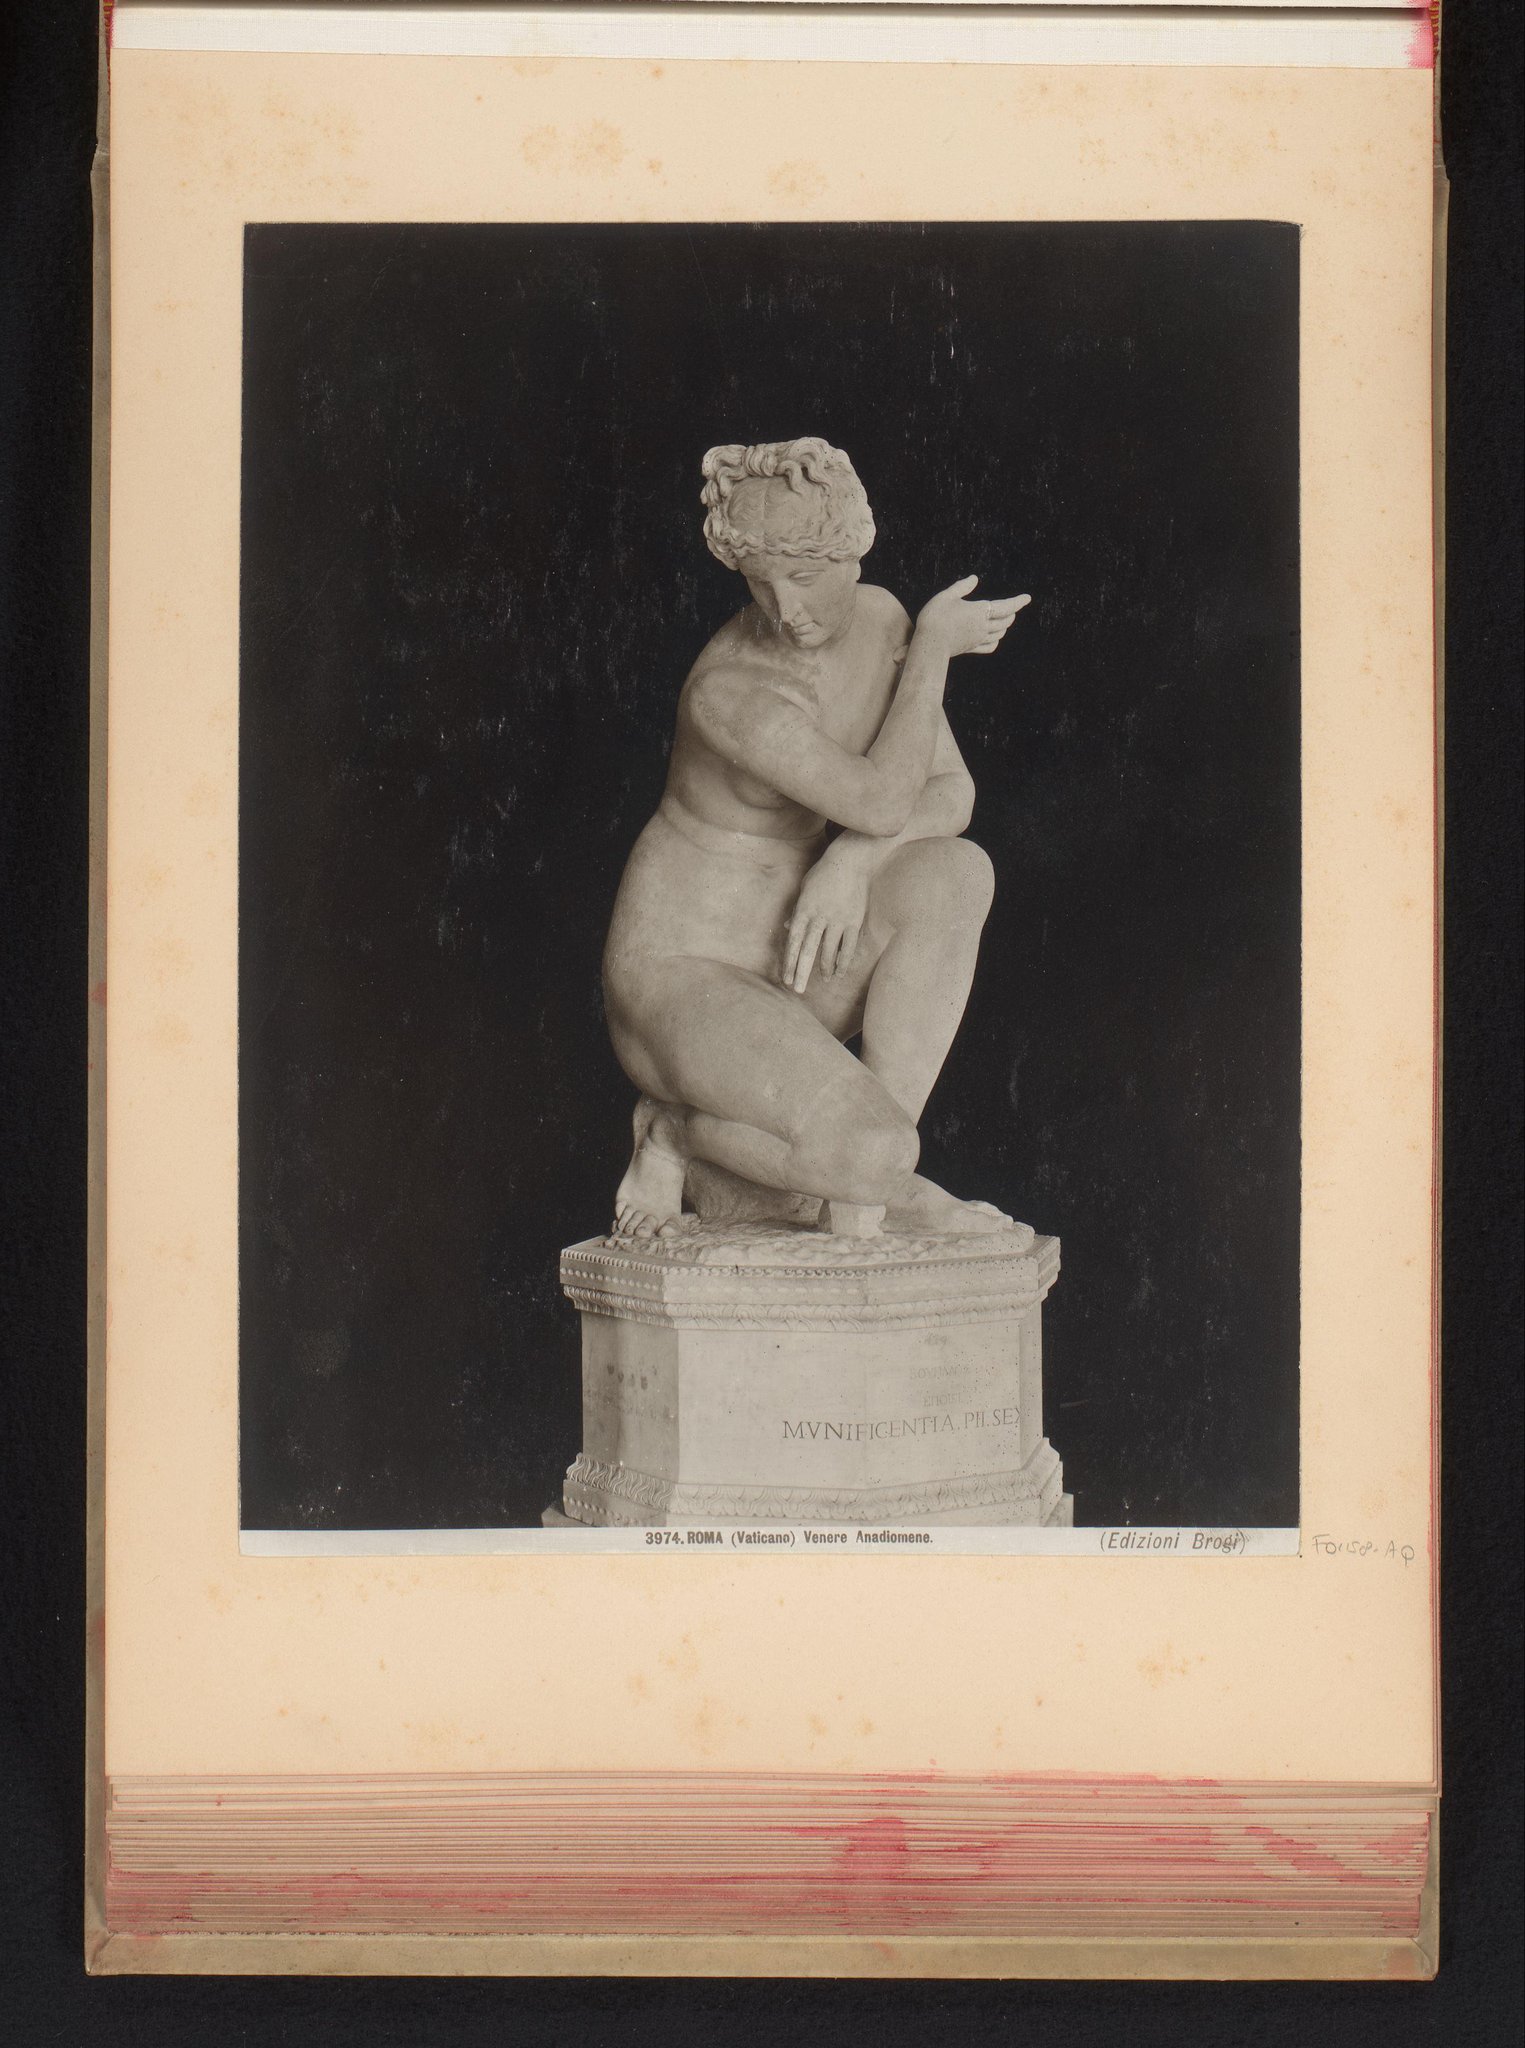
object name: photograph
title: Roma (Vaticano) Venere Anadiomene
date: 1875-1907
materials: photographic support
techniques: gelatin silver print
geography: vatican museums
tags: (story of) venus (aphrodite), sculpture, kneeling figure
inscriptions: number: ‘3974’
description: Onderdeel van Fotoalbum met opnames van bezienswaardigheden en kunstwerken in Italië.